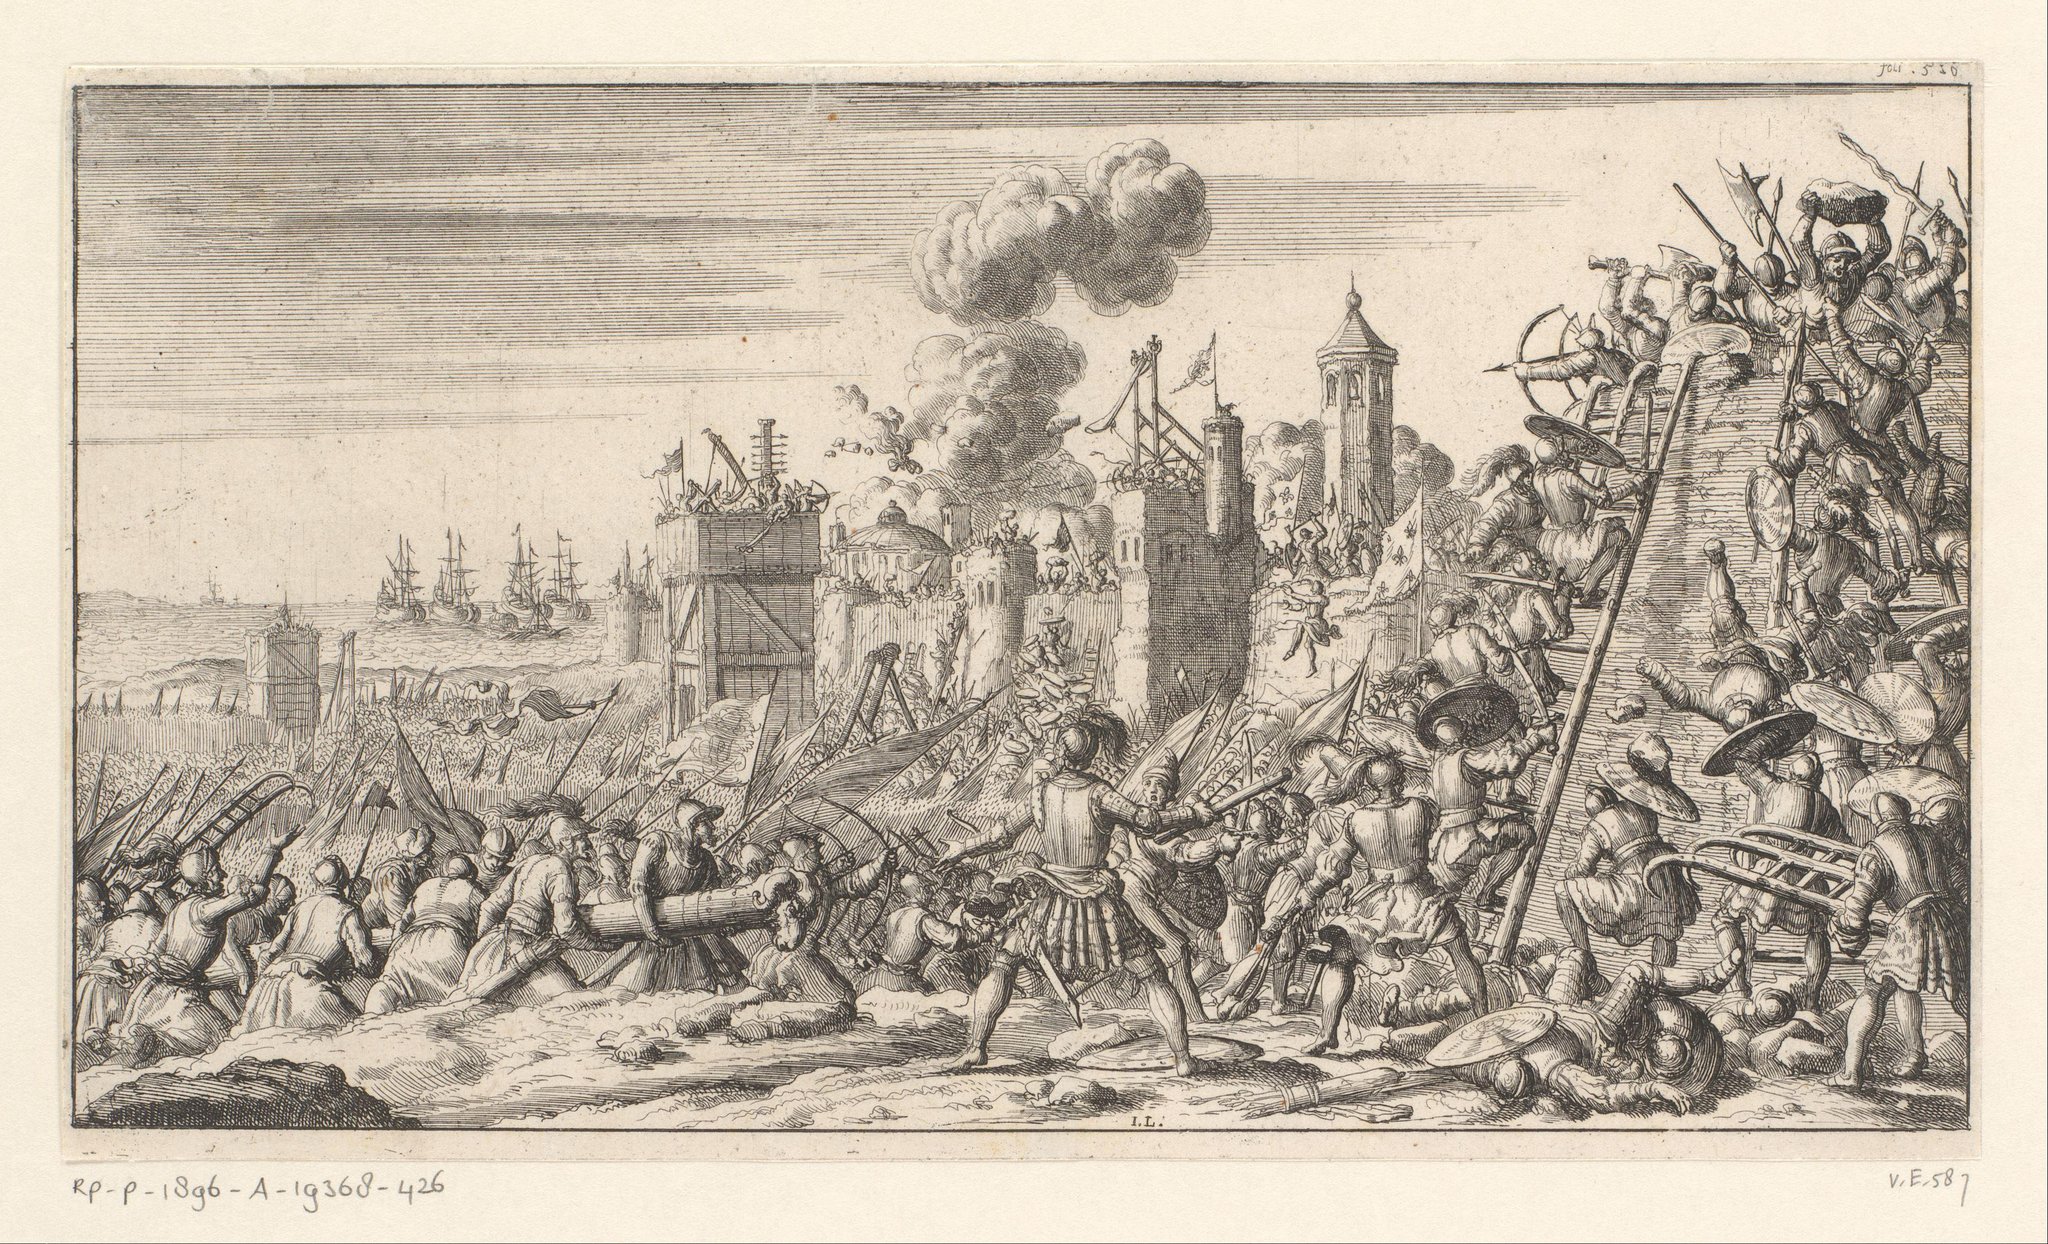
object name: print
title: Bestorming van de vesting Galata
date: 1683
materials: paper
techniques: etching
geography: amsterdam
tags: breaking into city or fortress ~ siege, militant proselytizing: religious war, crusade, etc.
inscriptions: collector's mark: Lugt 2228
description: Illustratie opgenomen in: Maimbourg, Louis. Historie der kruisvaarders, tot de verlossing van't heilig land. Amsterdam: Timotheus ten Hoorn, 1683.